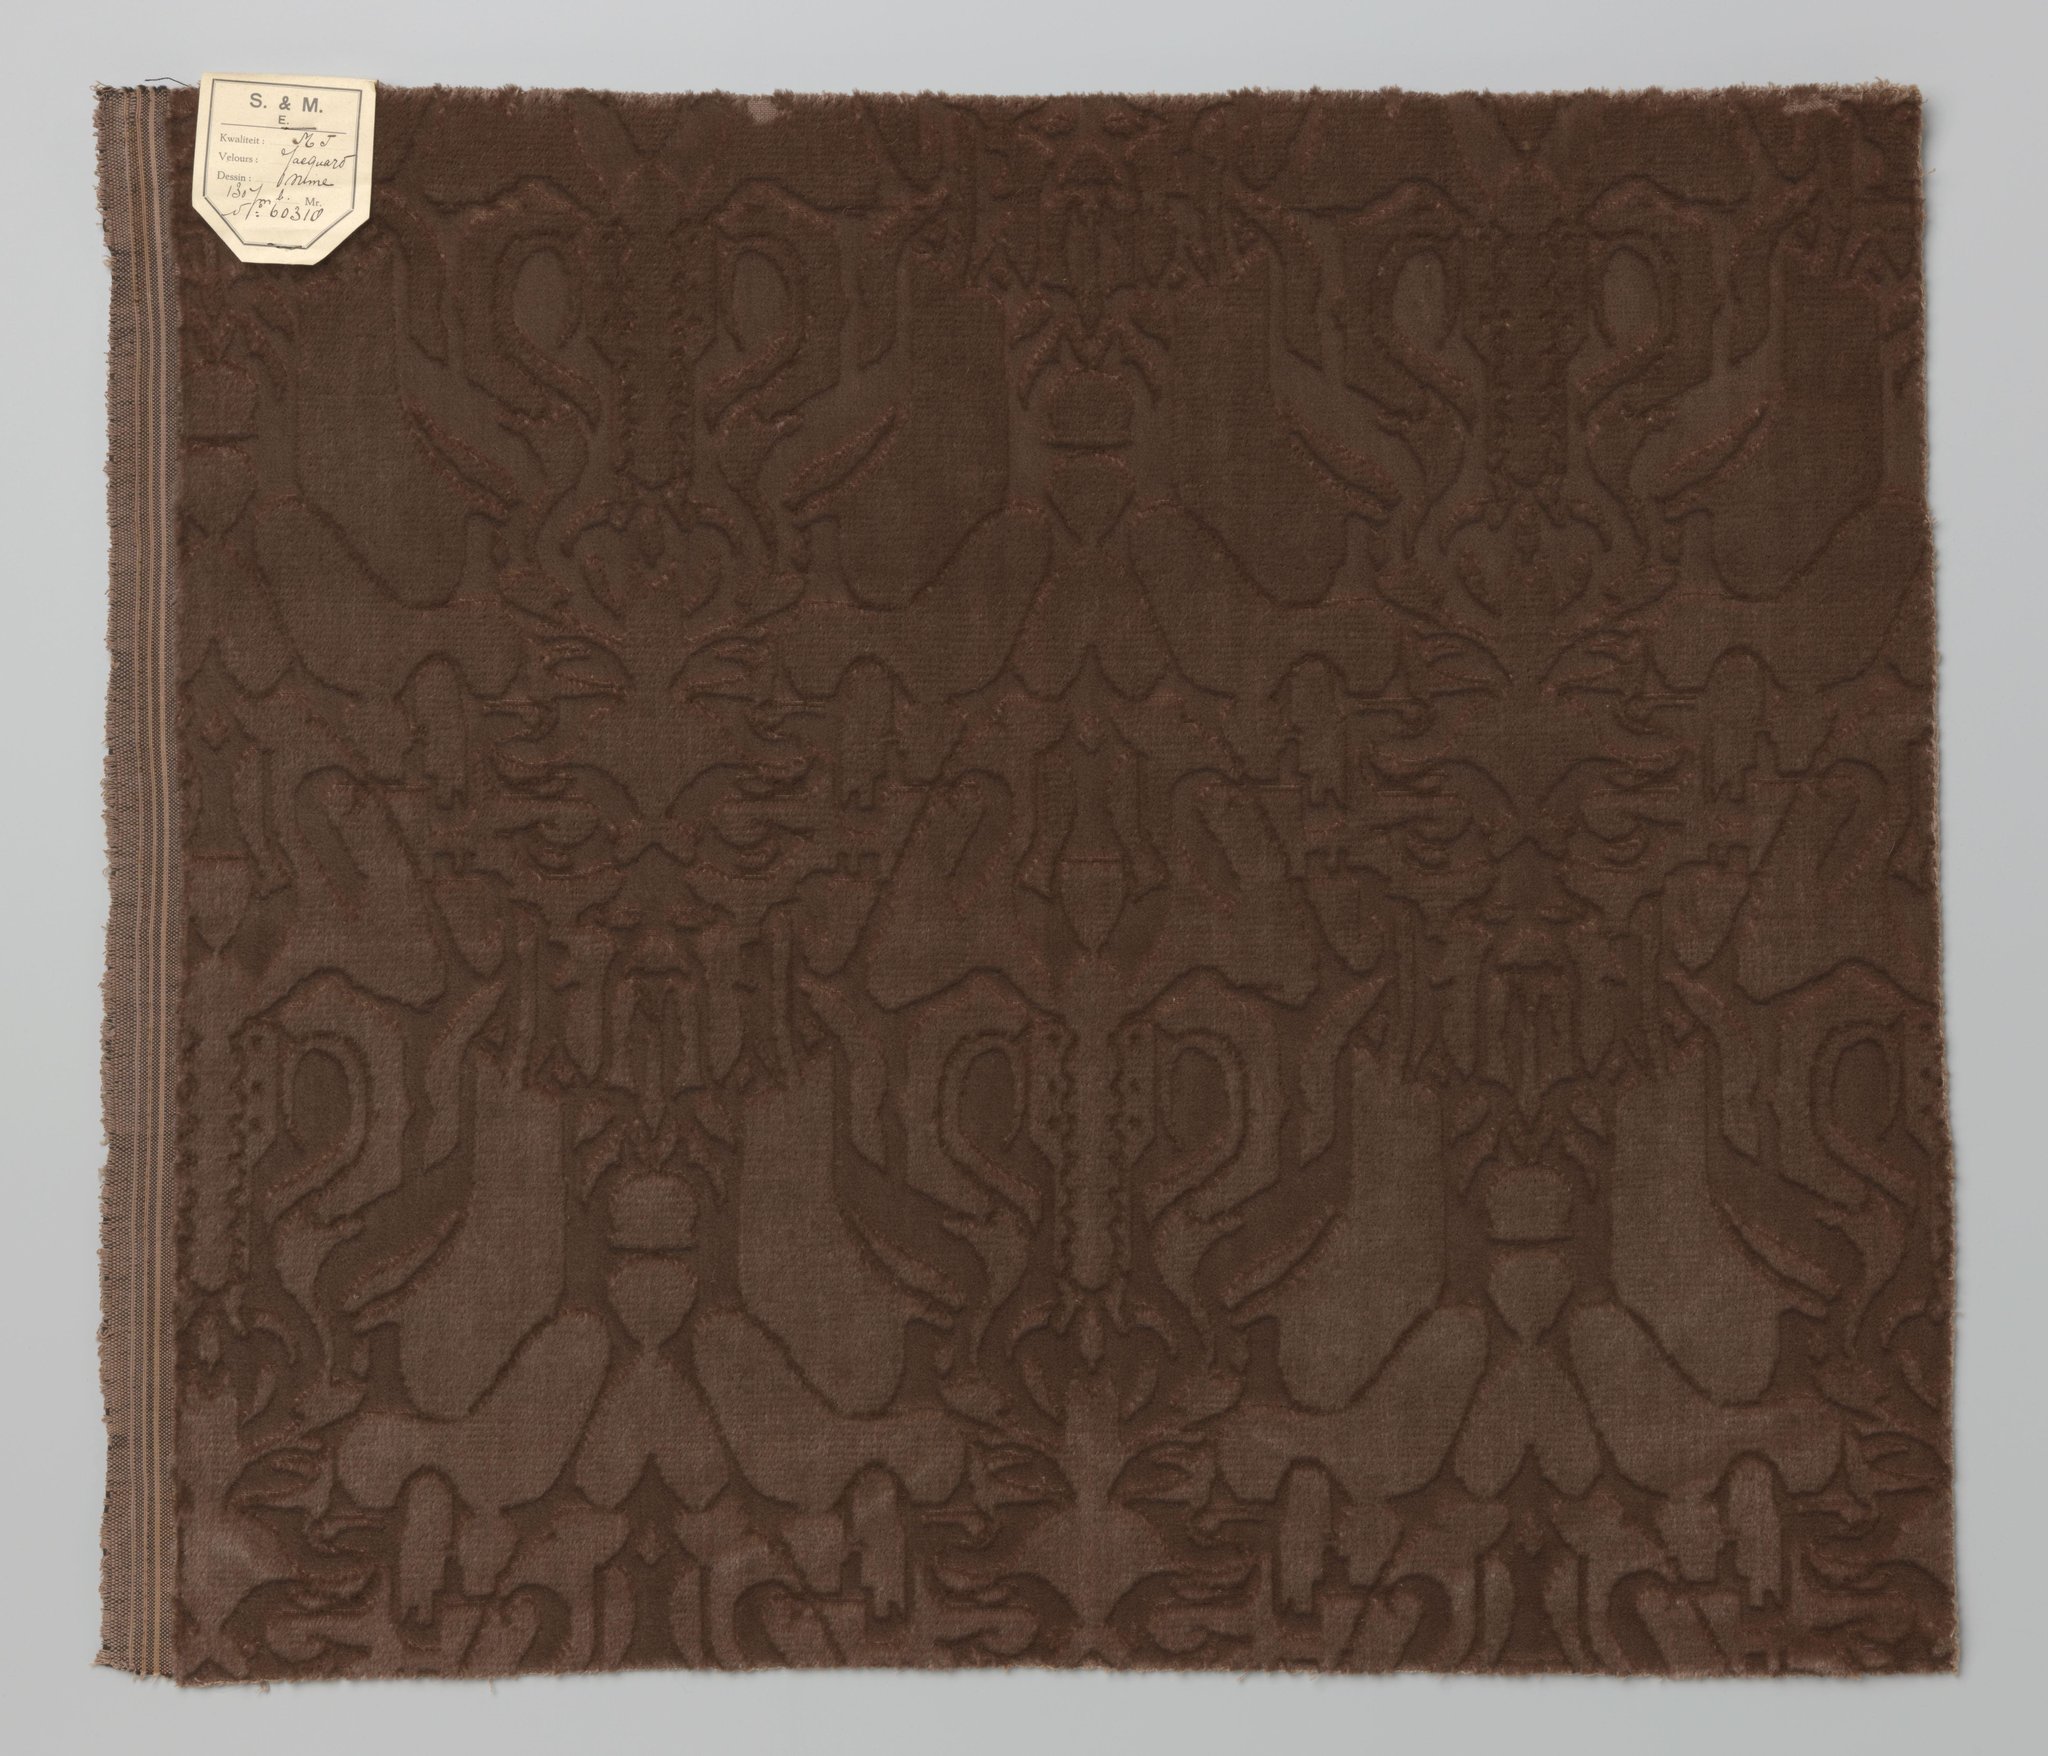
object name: bekledingsstof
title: Staal geperste trijp met abstracte motieven in de stijl van Art Deco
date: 1920-1925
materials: cotton, textile, hair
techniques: pressing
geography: netherlands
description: Staal bruine geperste trijp met abstracte motieven in de stijl van Art Deco. Aan de bovenkant van achterzijde is een klittenband bevestigd.